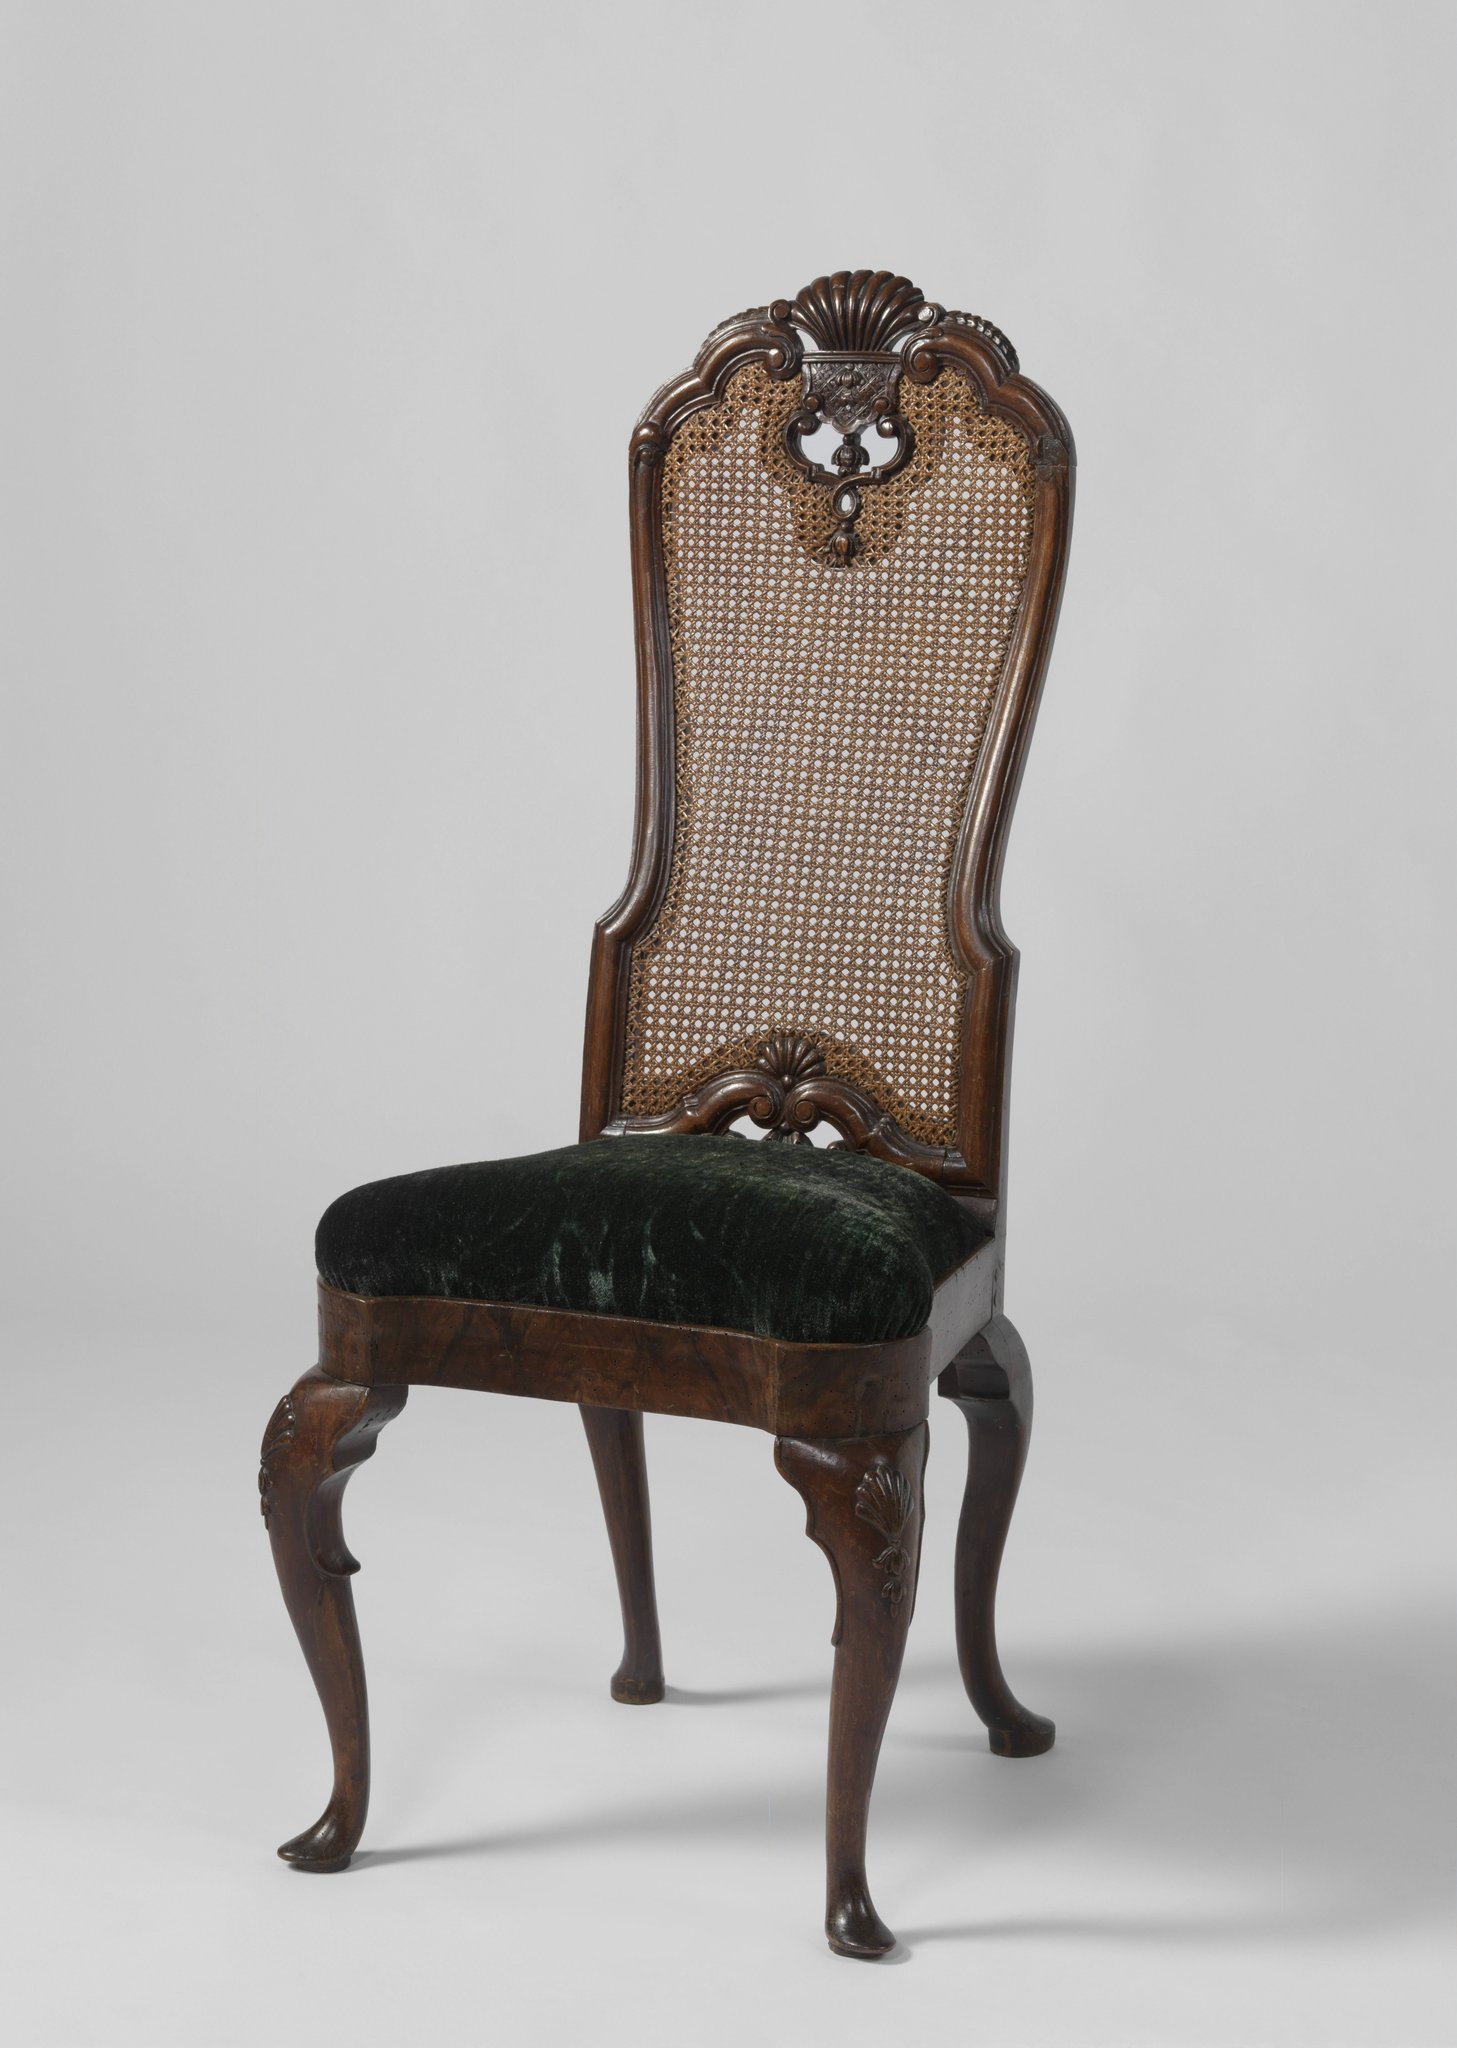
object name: furniture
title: Stoel met schelpmotief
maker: Anonymous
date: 1700-1750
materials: wood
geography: northern netherlands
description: Stoel van notenhout. Het meubel heeft op de zitting een op los raam aangebrachte bekleding en op de rug een rietbespanning. Het rust op overhoeks geplaatste, S-vormige poten; de voorpoten zijn op de zwelling versierd met een schelp en een klokje. Het rugraam is licht horizontaal gehold en heeft in het bovengedeelte gestrekt S-vormige hoekstijlen. De bovendorpel vertoont gebroken C-voluten ter weerszijden van een opengewerkt middenstuk met schelpmotief boven een lambrekijn en klokjes.